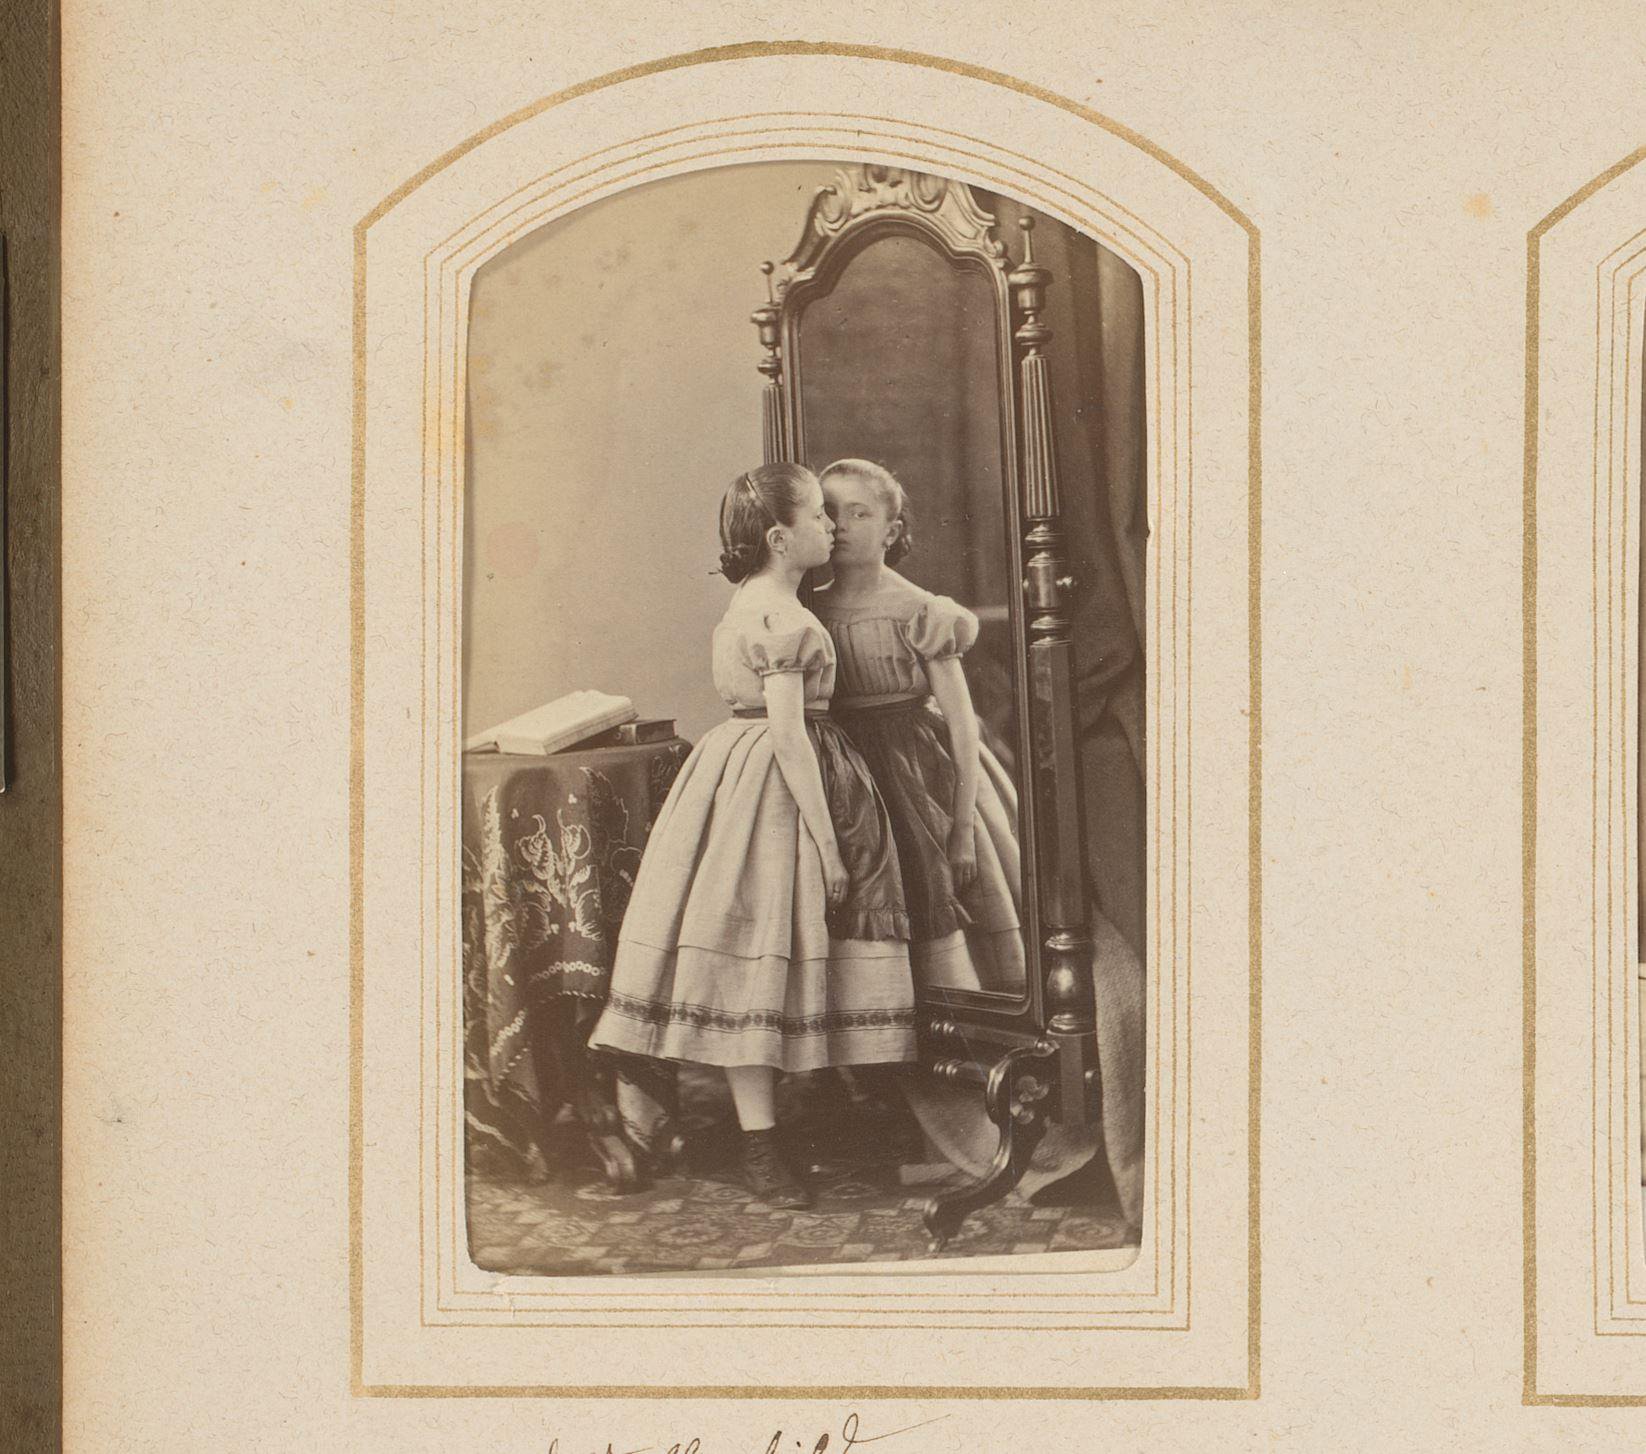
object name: carte de visite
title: Meisje voor de spiegel met open fotoalbum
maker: godfried de jong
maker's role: print maker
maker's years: 1832-1918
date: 1870-1880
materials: cardboard, photographic support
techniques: albumen print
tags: mirror, girl (child between toddler and youth)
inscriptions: annotation: ‘Das Ebenbild’, number: ‘1146’